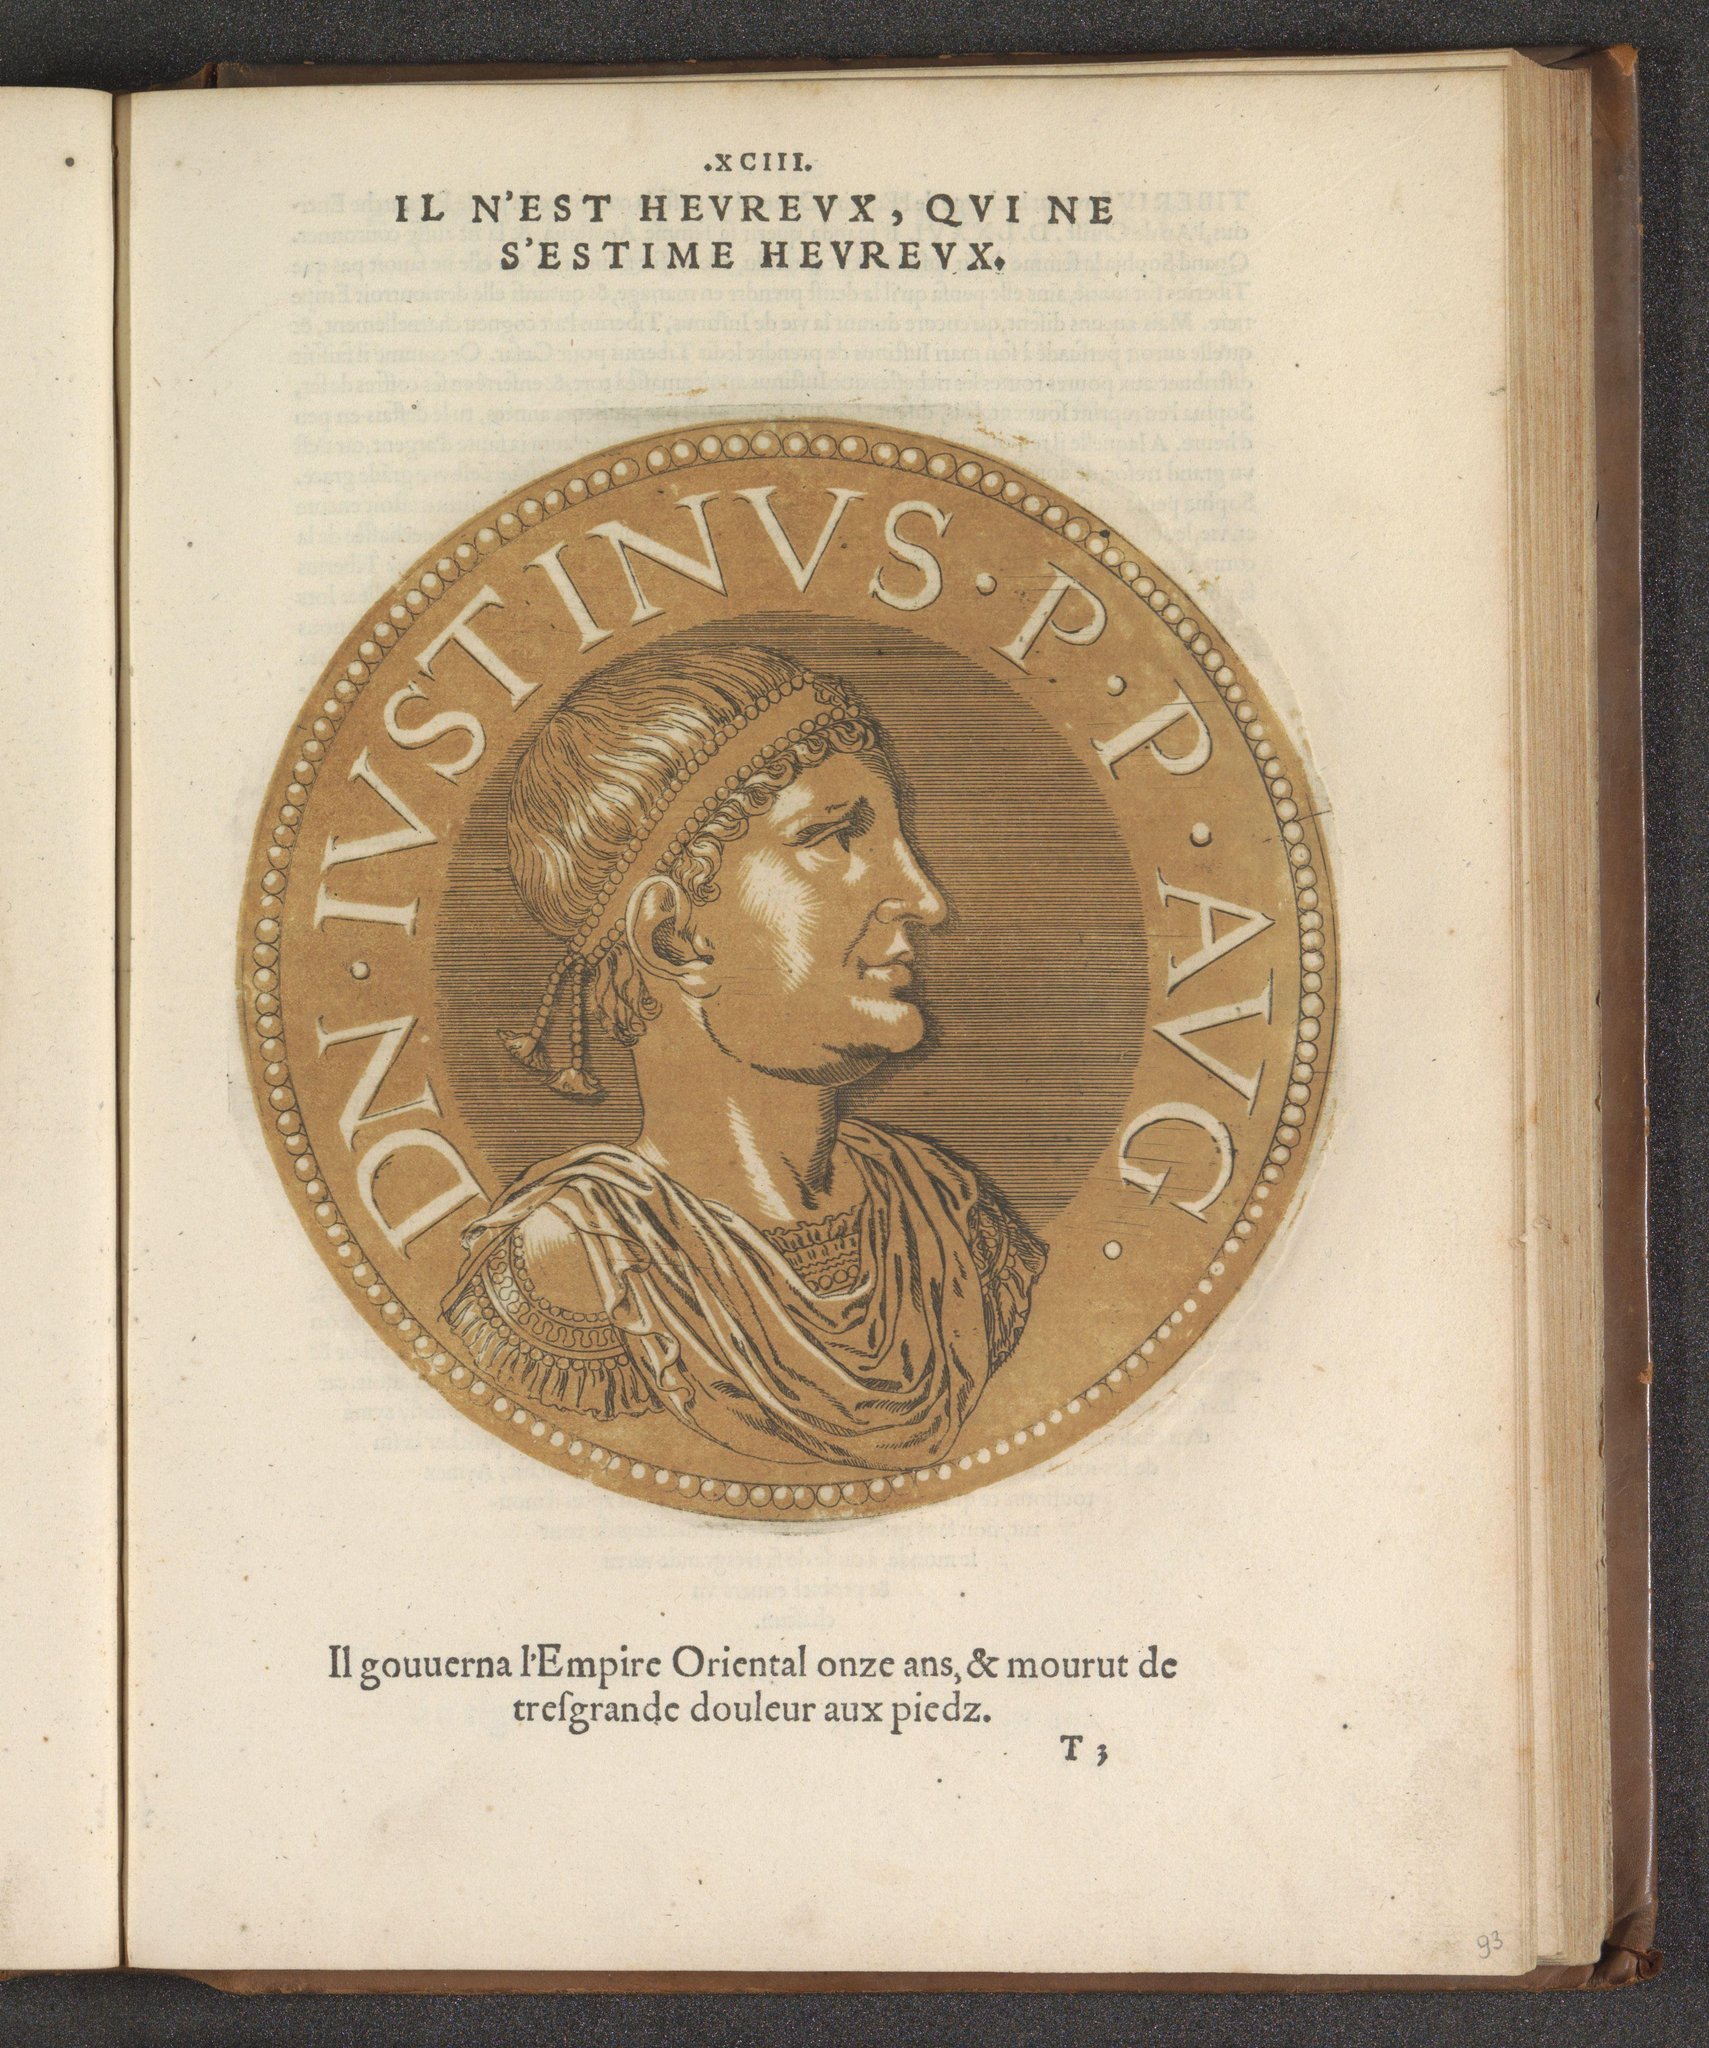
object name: page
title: Les images presque de tous les empereurs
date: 1557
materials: paper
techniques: woodcut, etching, letterpress printing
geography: antwerp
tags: emperor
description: Portret van keizer Justinus II, op een munt met randschrift. De prent maakt deel uit van een boek over de keizers vanaf Julius Caesar tot en met Karel V en zijn broer Ferdinand.